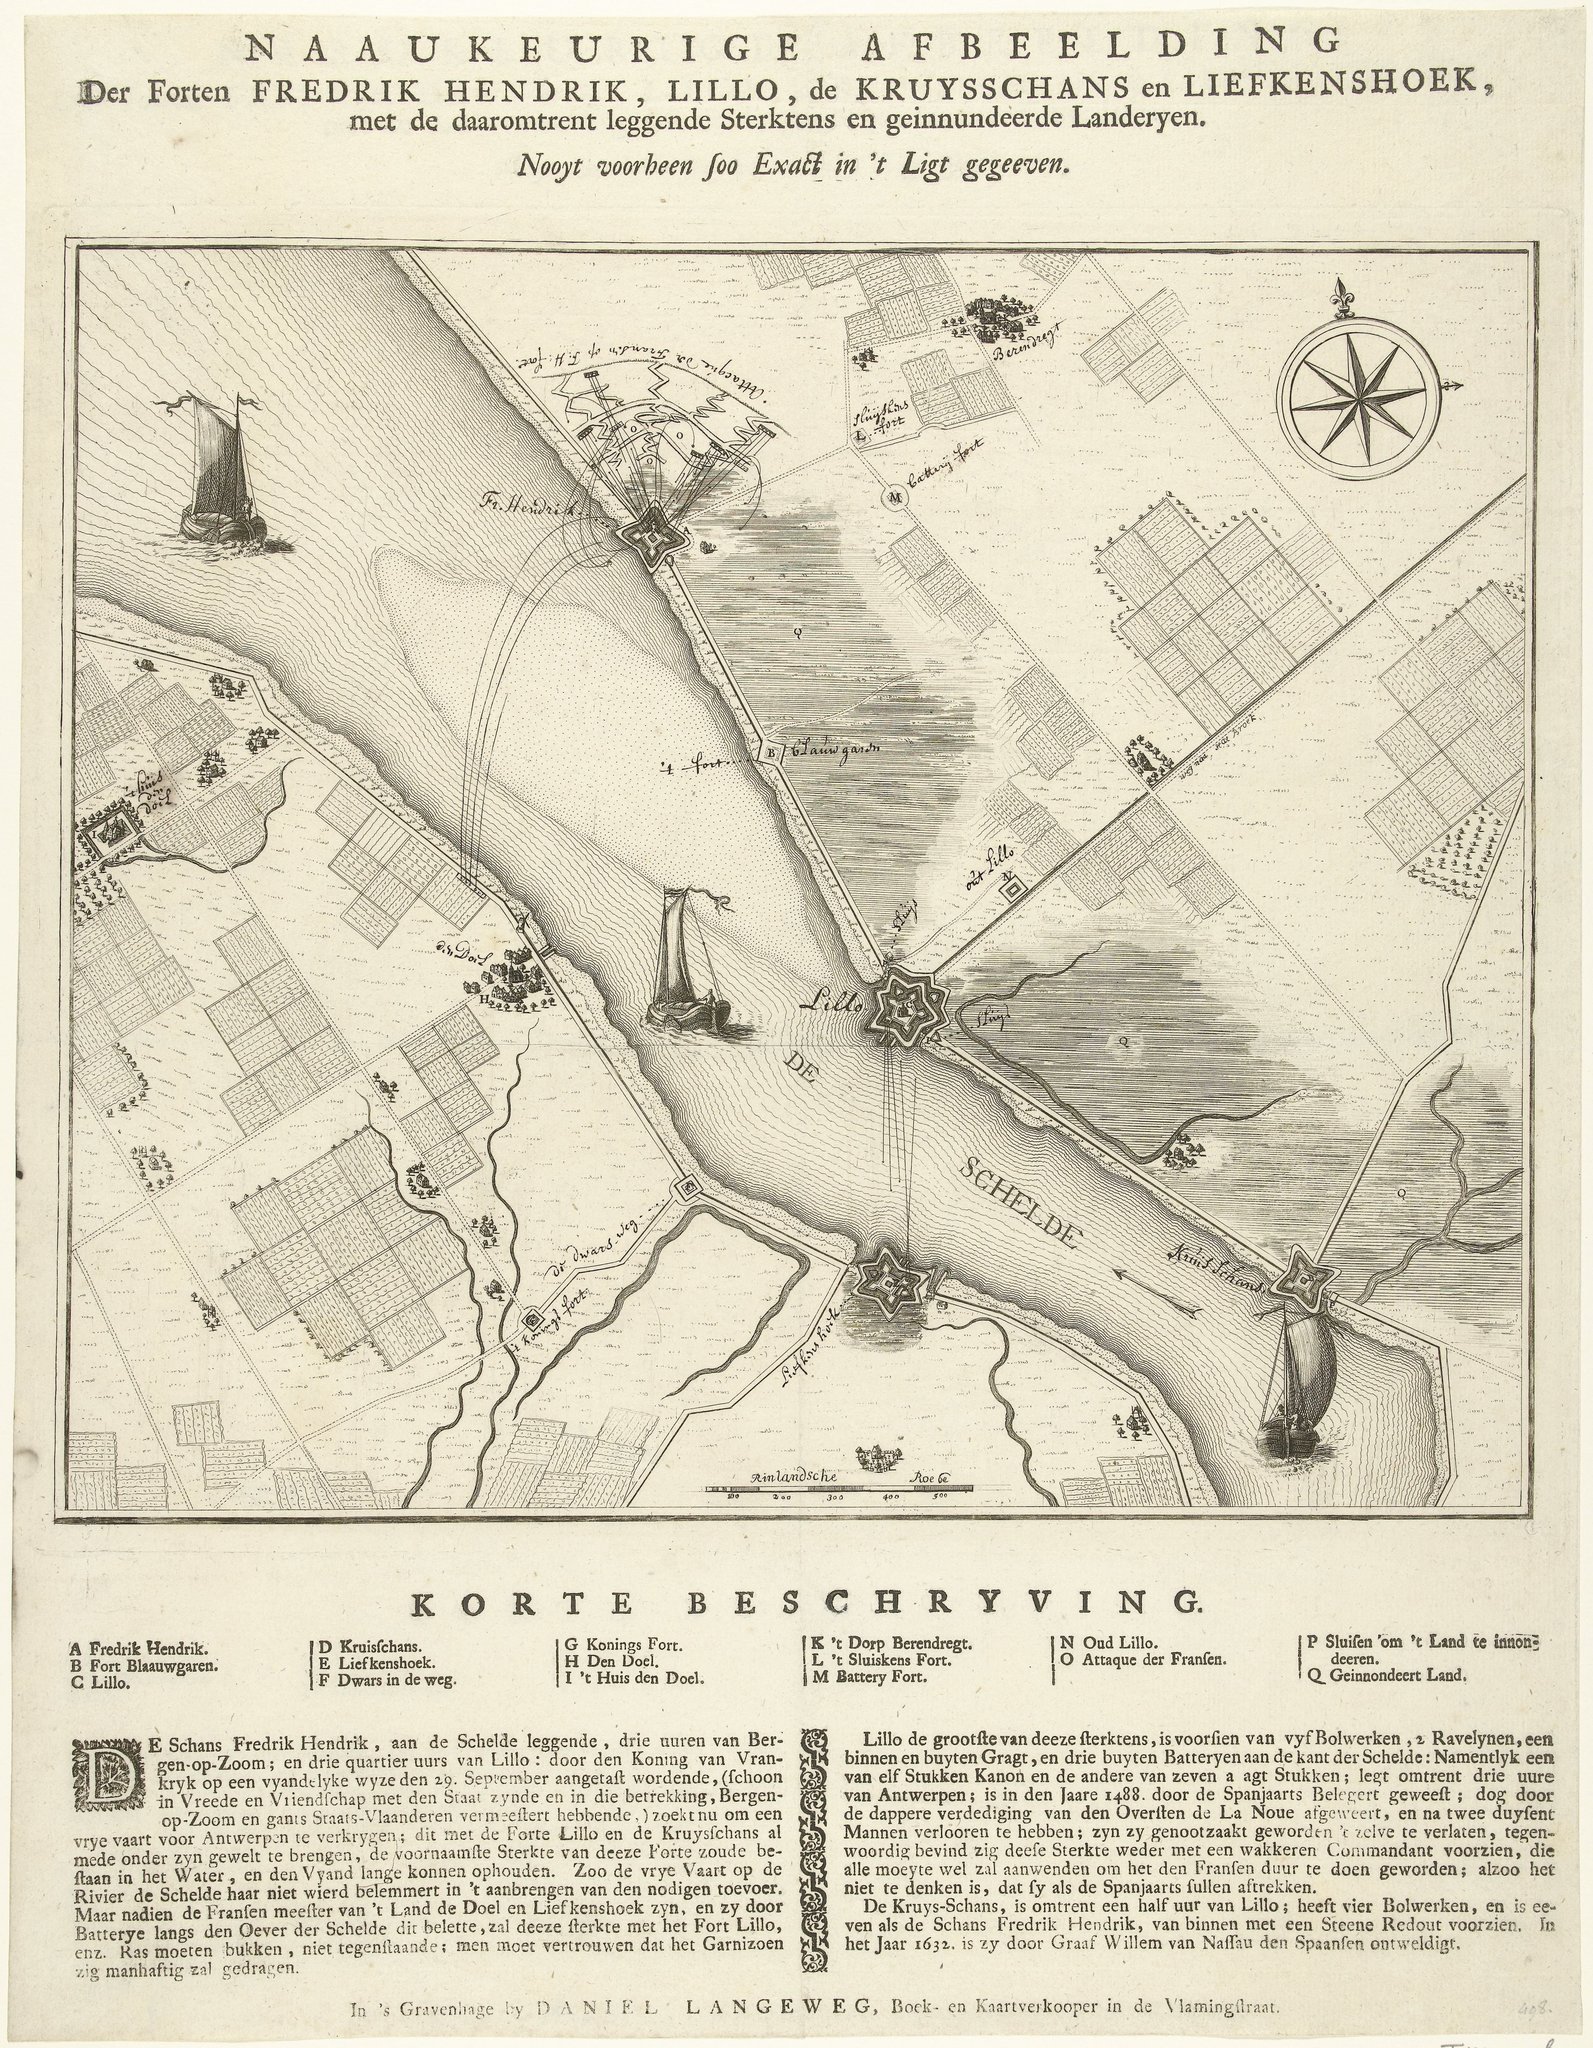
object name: map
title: Naaukeurige Afbeelding Der Forten Fredrik Hendrik, Lillo, de Kruysschans en Liefkenshoek, met de daaromtrent leggende Sterktens en geinnundeerde Landeryen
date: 1747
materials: paper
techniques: etching, letterpress printing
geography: the hague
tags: fortress, maps of separate countries or regions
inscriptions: collector's mark: Lugt 2228, collector's mark: ‘G’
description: Kaart met de belegering van de Nederlandse forten Frederik Hendrik, Lillo, Kruisschans en Liefkenshoek, gelegen aan de Schelde, door de Fransen tussen 1 en 14 oktober 1747, en de geïnundeeerde gebieden. Met opschriften in pen in de voorstelling. Op het blad onder de plaat een beschrijving van de forten in twee kolommen.